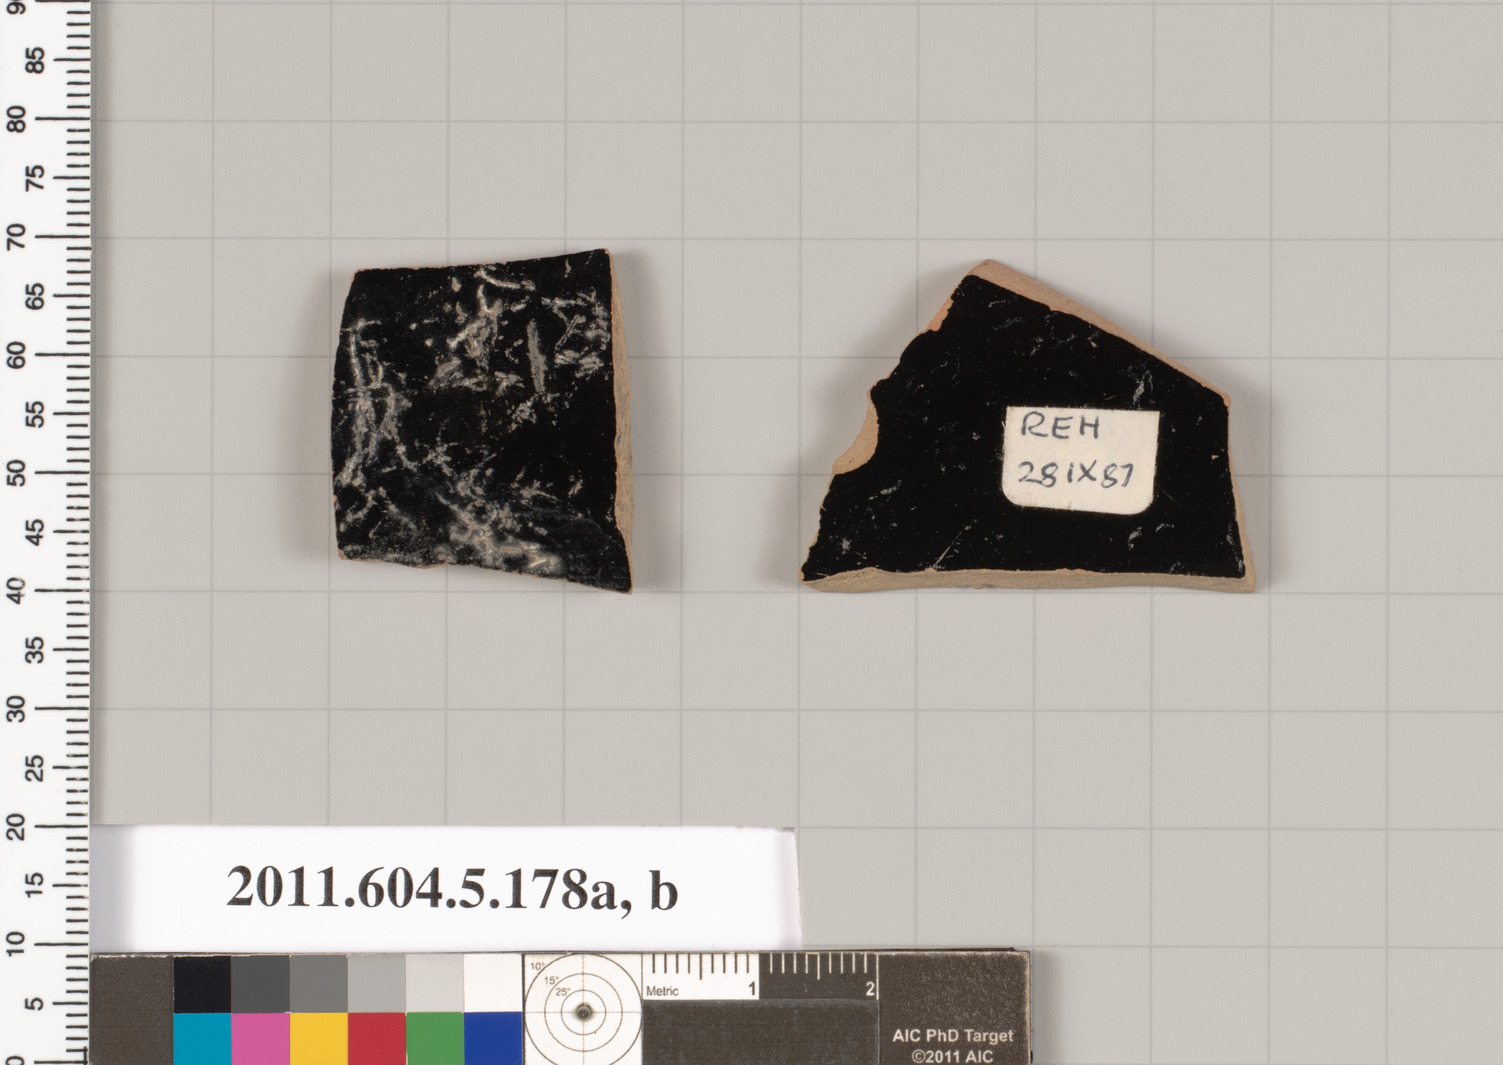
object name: kylix fragment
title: Terracotta fragments of kylikes (drinking cups)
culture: greek, attic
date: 600-401 BCE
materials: terracotta